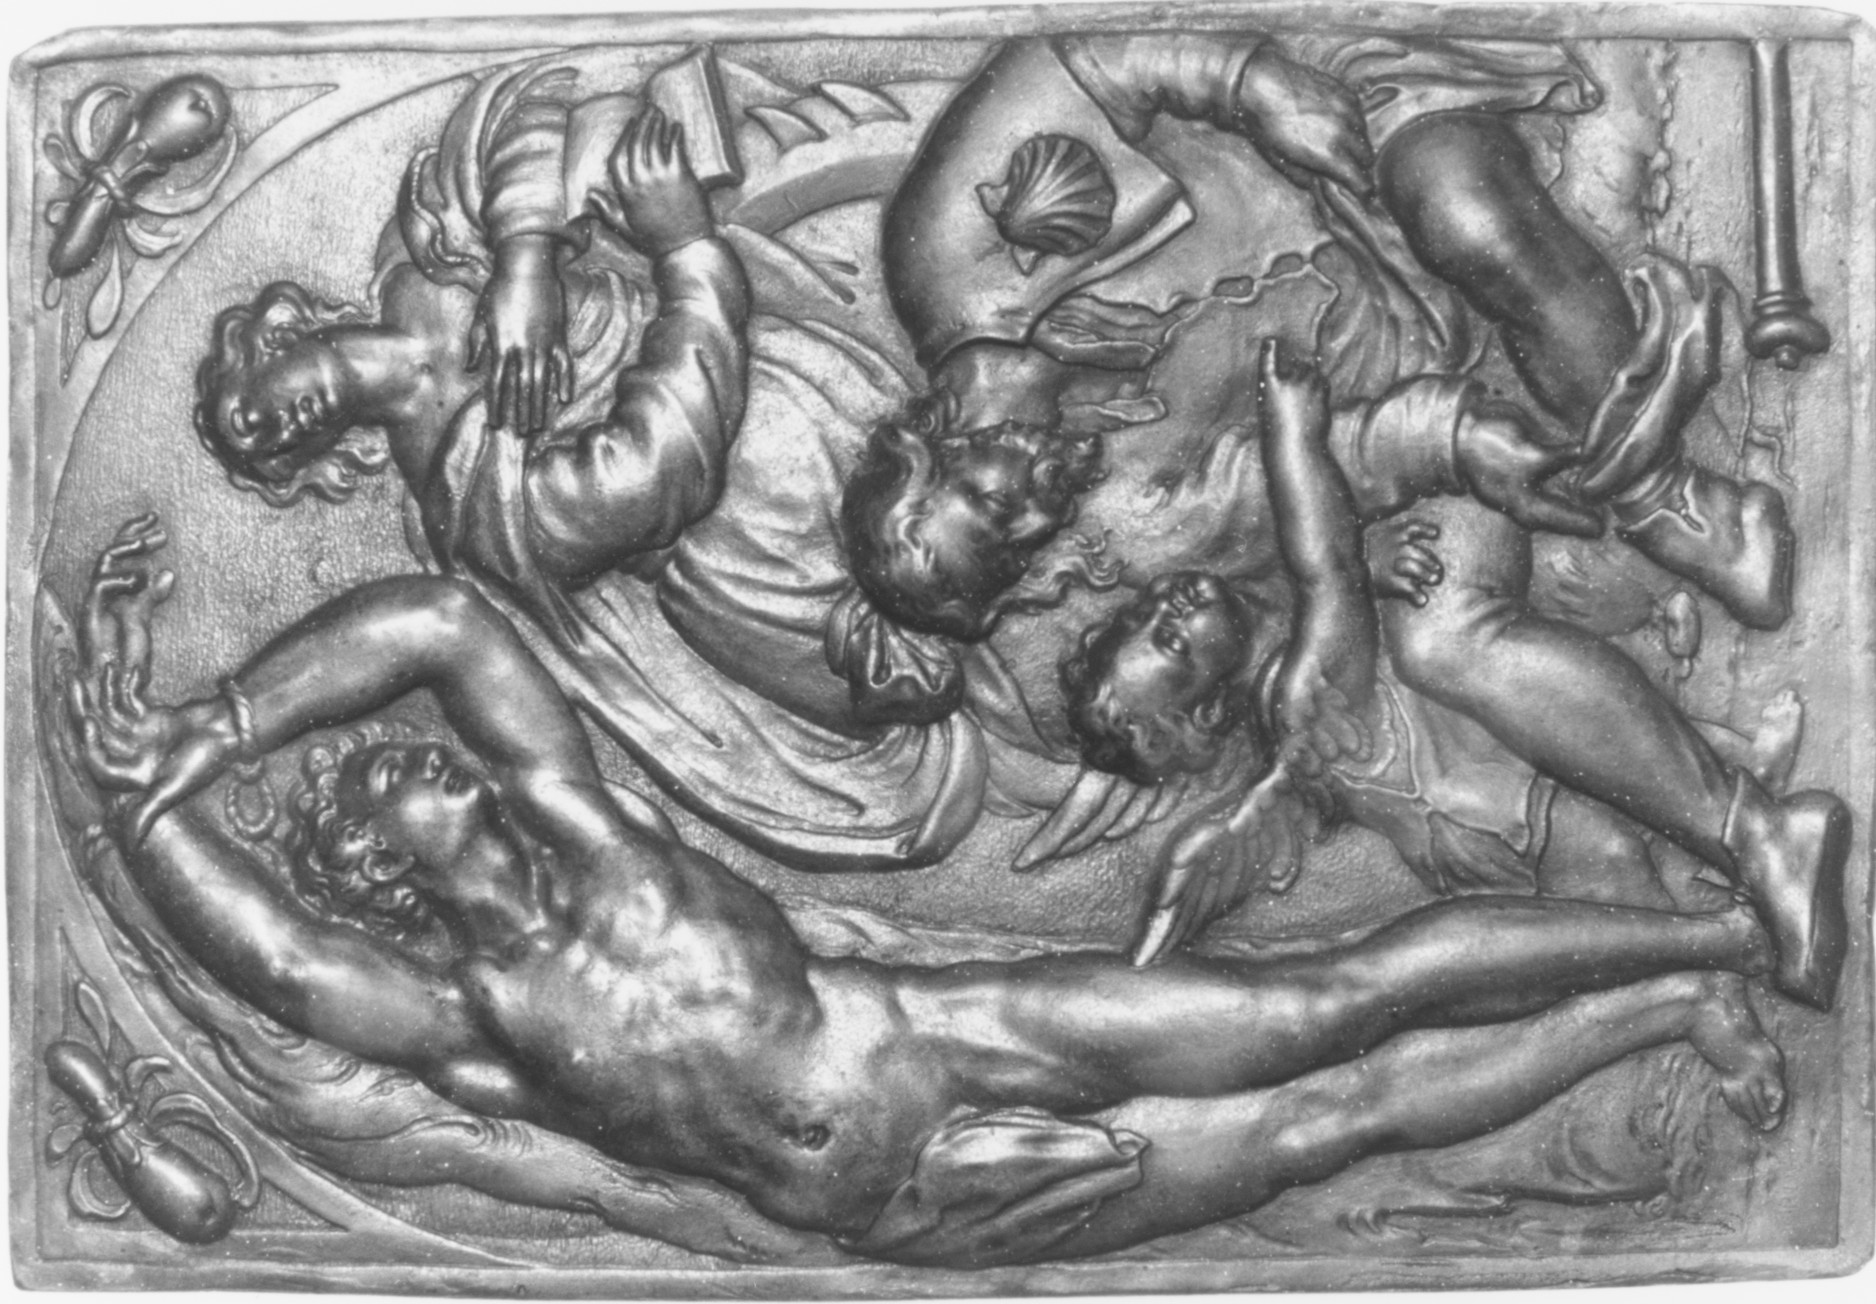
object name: plaquette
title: Ss. Sebastian, Catherine and Roch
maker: paulus willemsz. van vianen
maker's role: artist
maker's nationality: netherlandish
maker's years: 1565-1619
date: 1567-1633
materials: bronze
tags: men,women,putti,saint catherine,saints